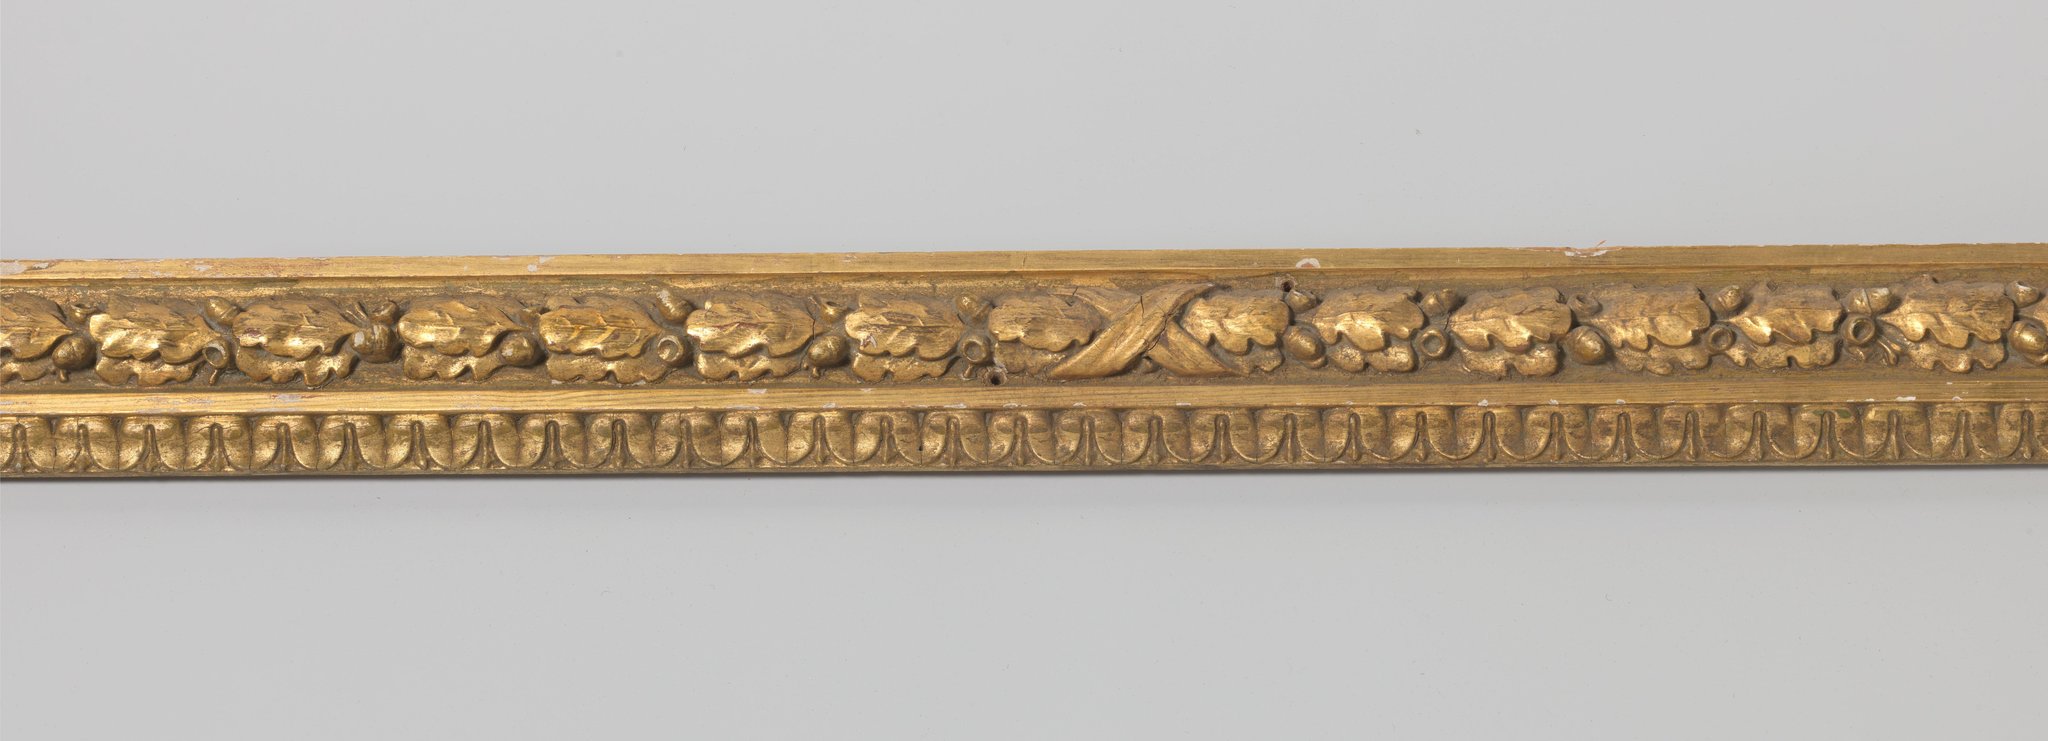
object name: frame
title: Lijstfragment: vergulde lijst met pâte-ornamenten, bovenregel.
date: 1700-1899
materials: gold leaf, wood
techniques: gilding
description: Vergulde lijst met eikenbladeren met eikeltjes. Lijstdeel, boven regel. Met achterop geschreven: 'Top, no. 2'.